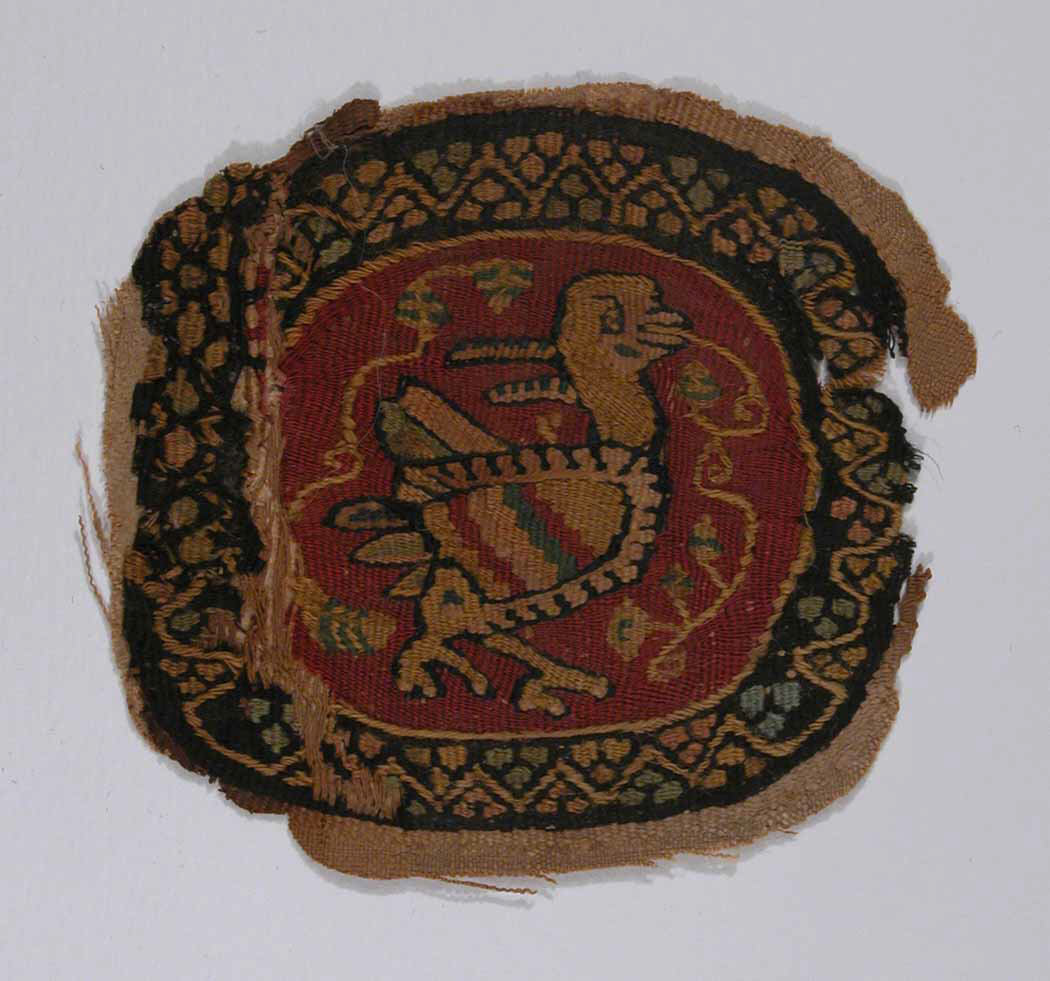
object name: roundel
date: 501-600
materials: linen, wool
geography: egypt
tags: birds